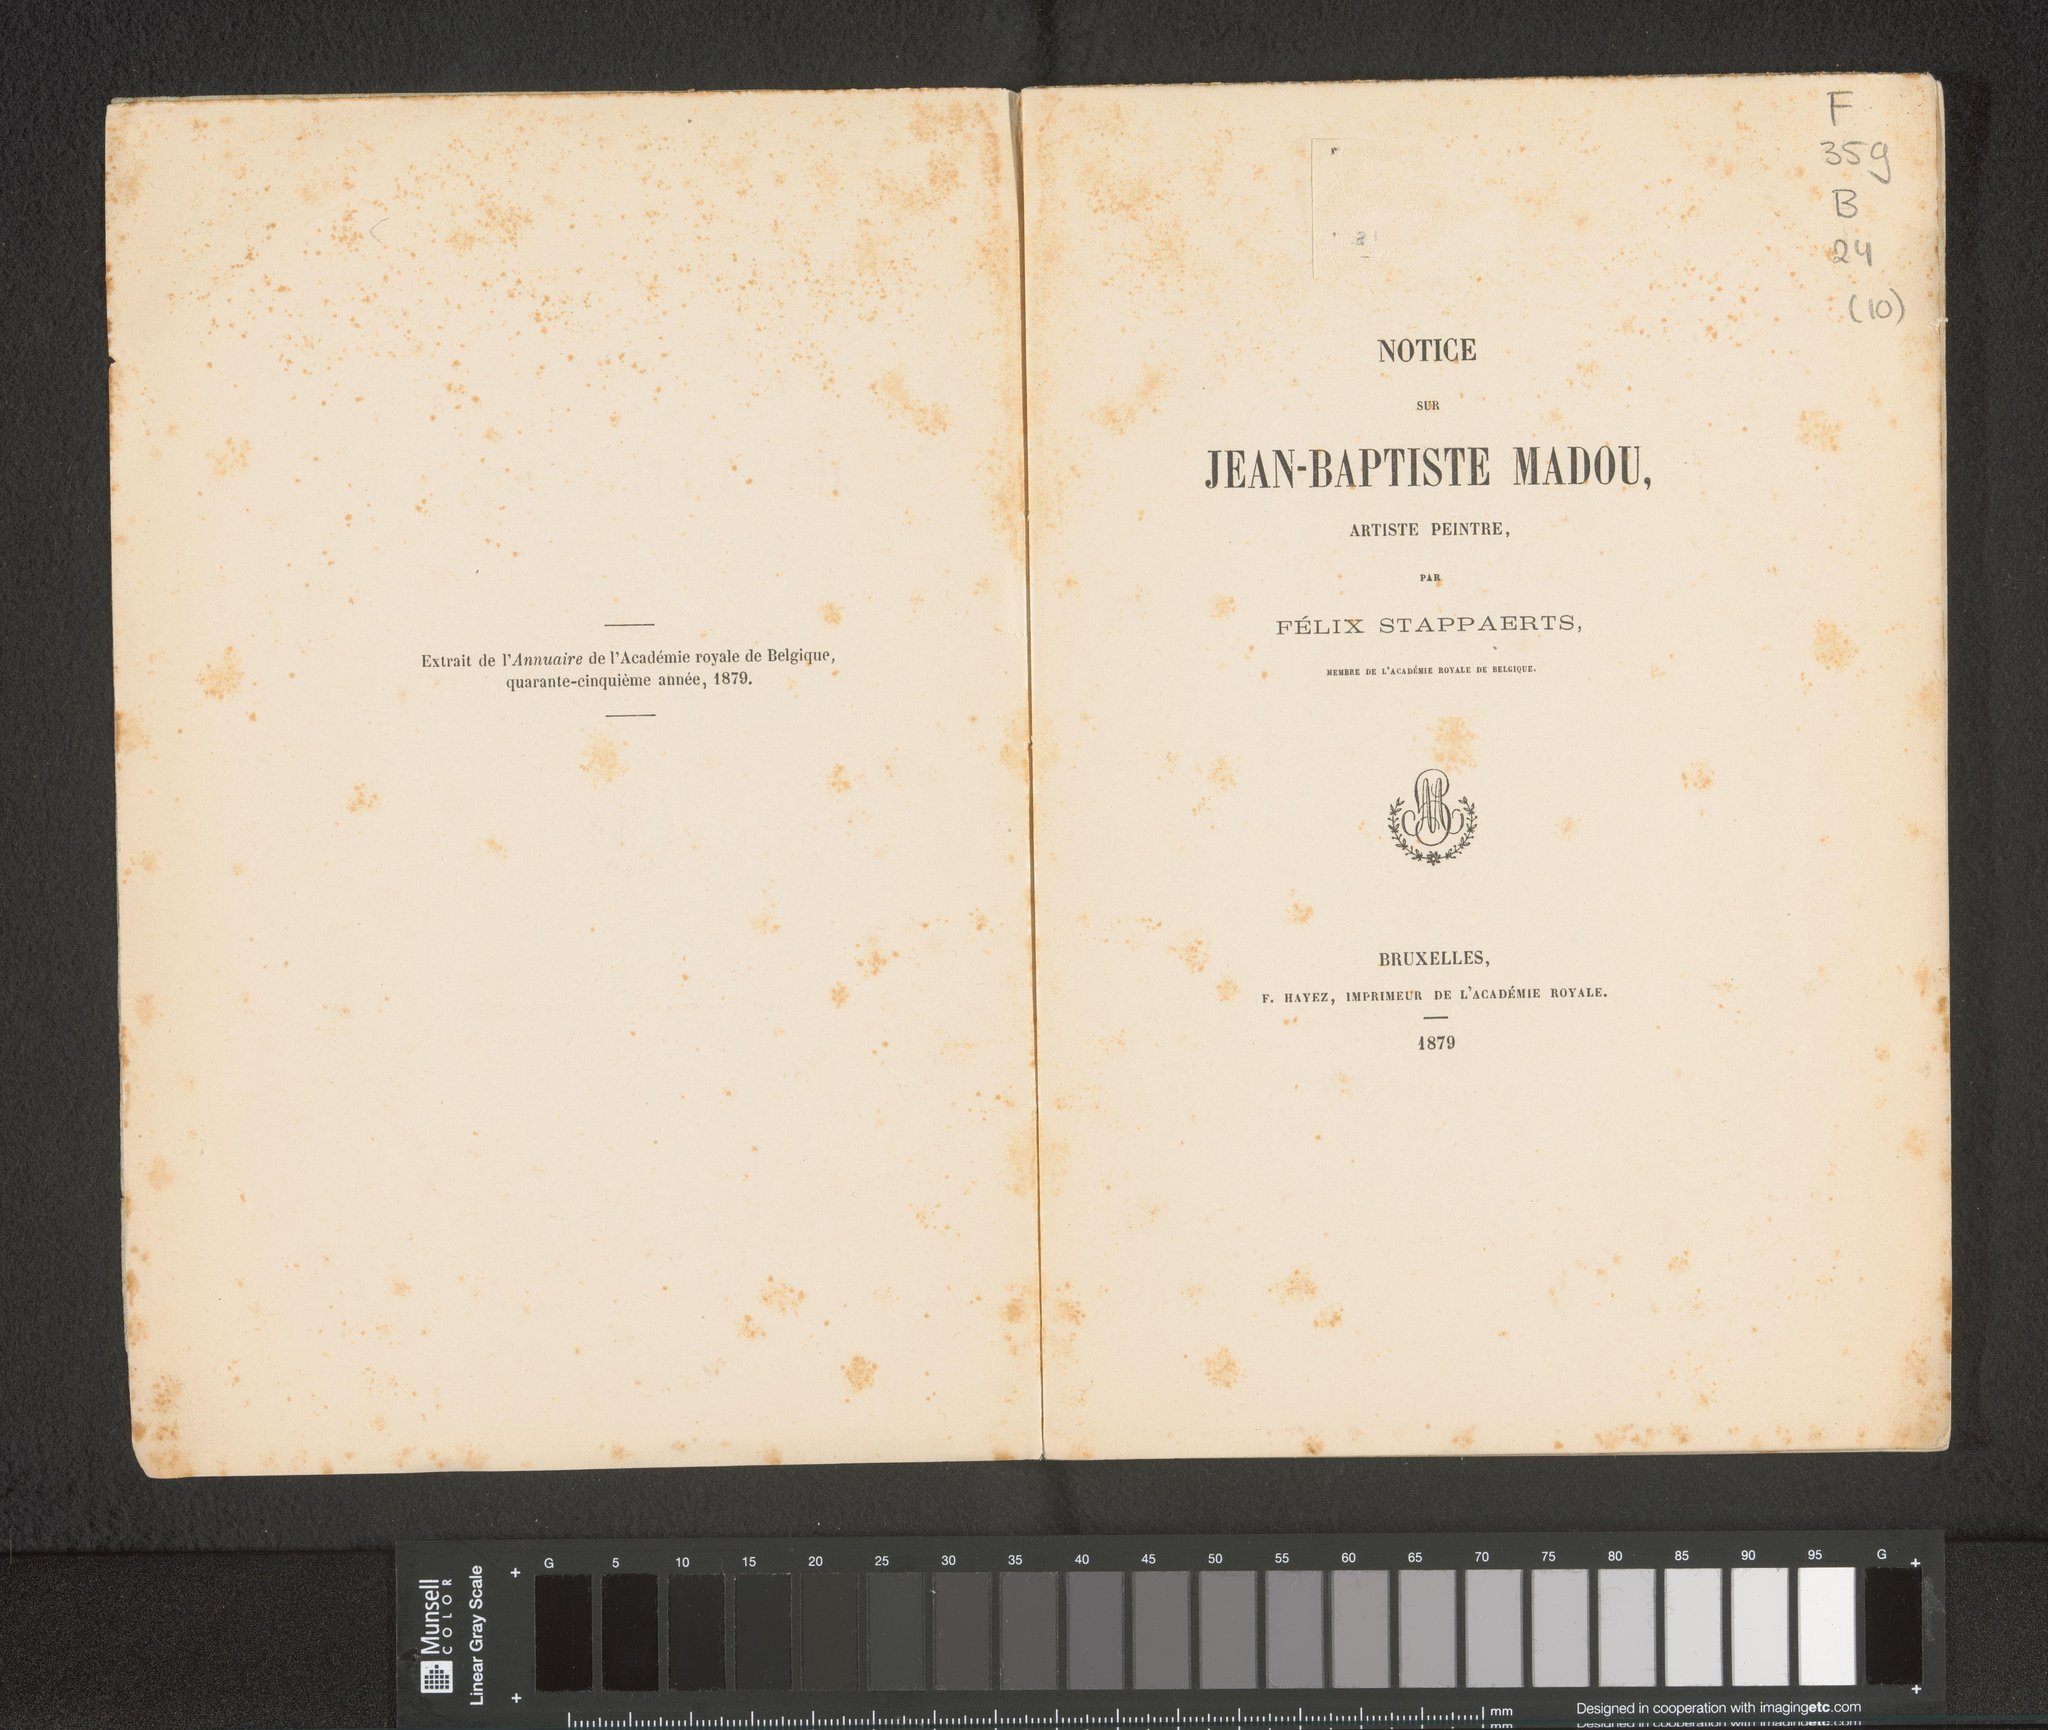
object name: book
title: Notice sur Jean-Baptiste Madou, artiste peintre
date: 1879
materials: paper, photographic support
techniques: albumen print, printing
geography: brussels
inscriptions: annotation: ‘SEPT/ 1999’